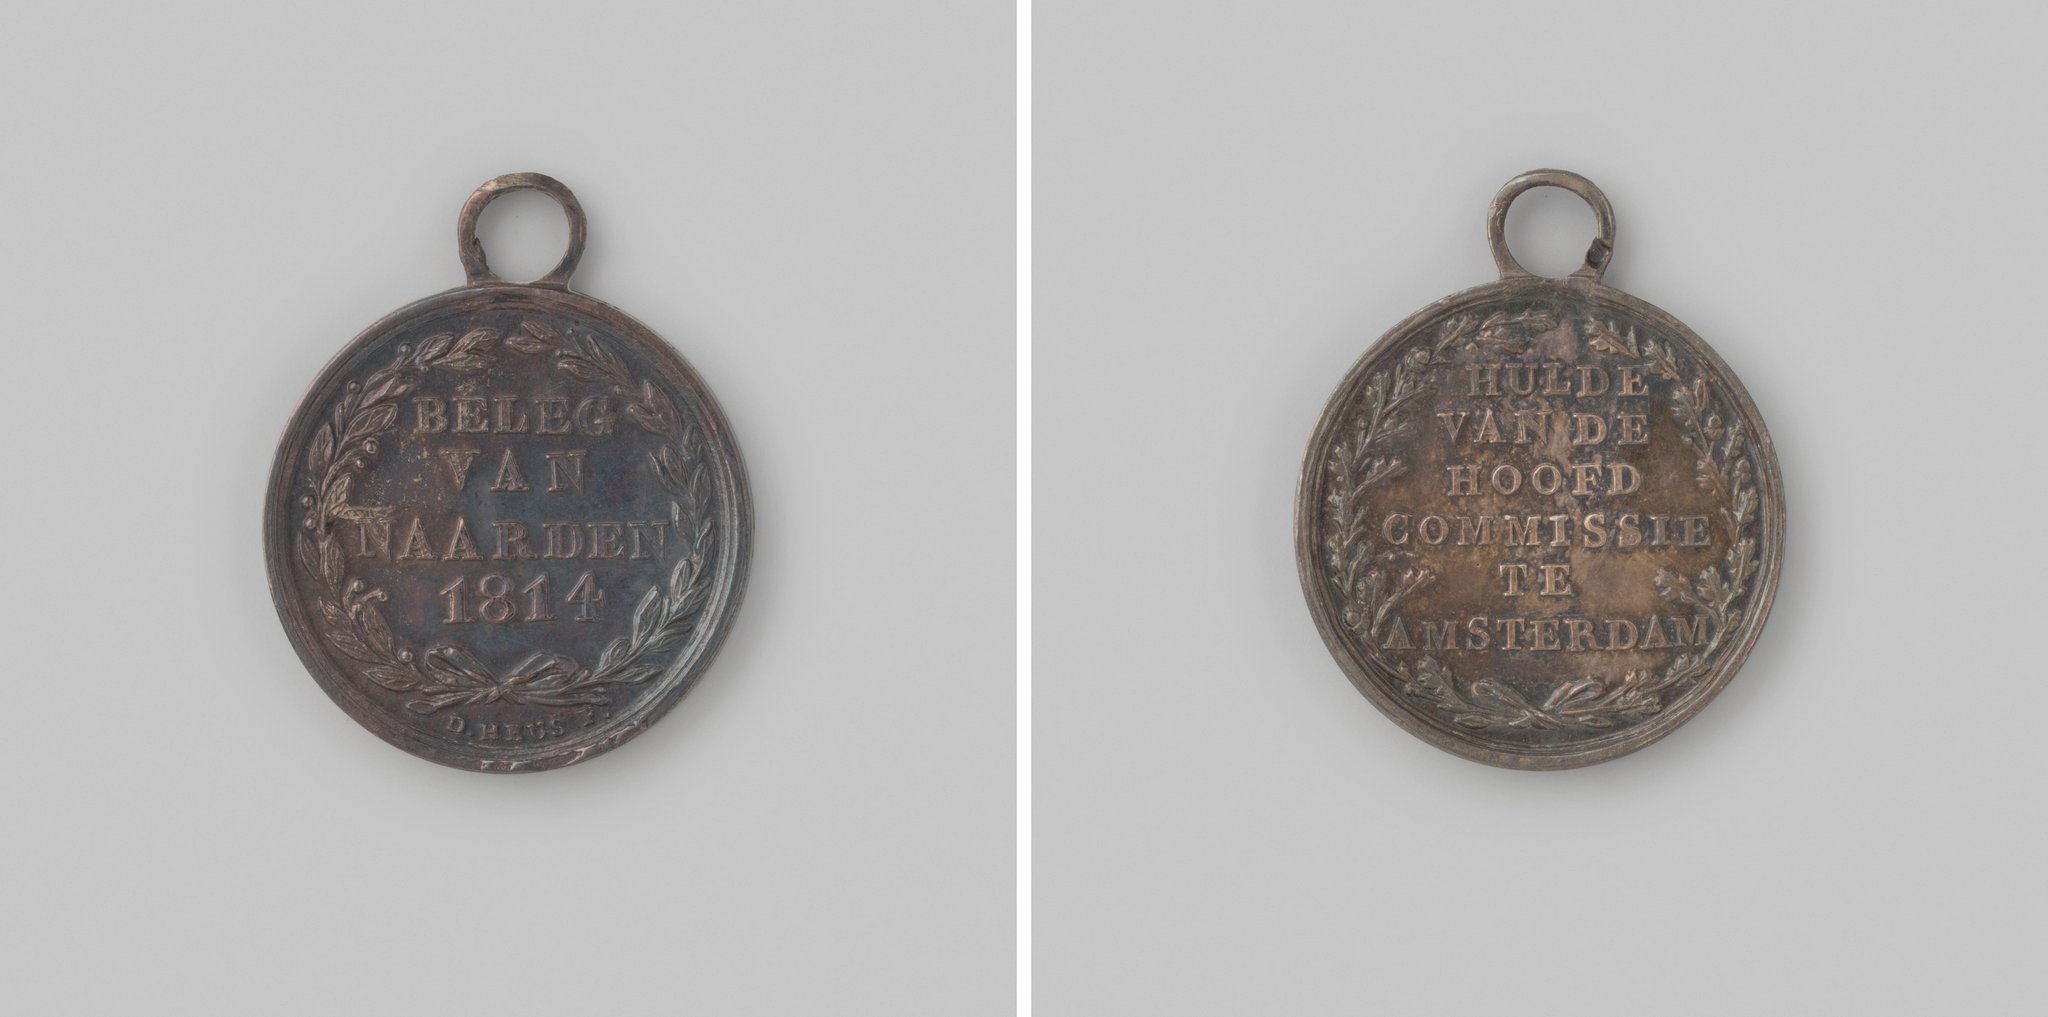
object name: honorary medal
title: Erepenning voor de schutters bij het beleg van Naarden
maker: hendrik de heus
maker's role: medailleur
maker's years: -1838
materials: bronze